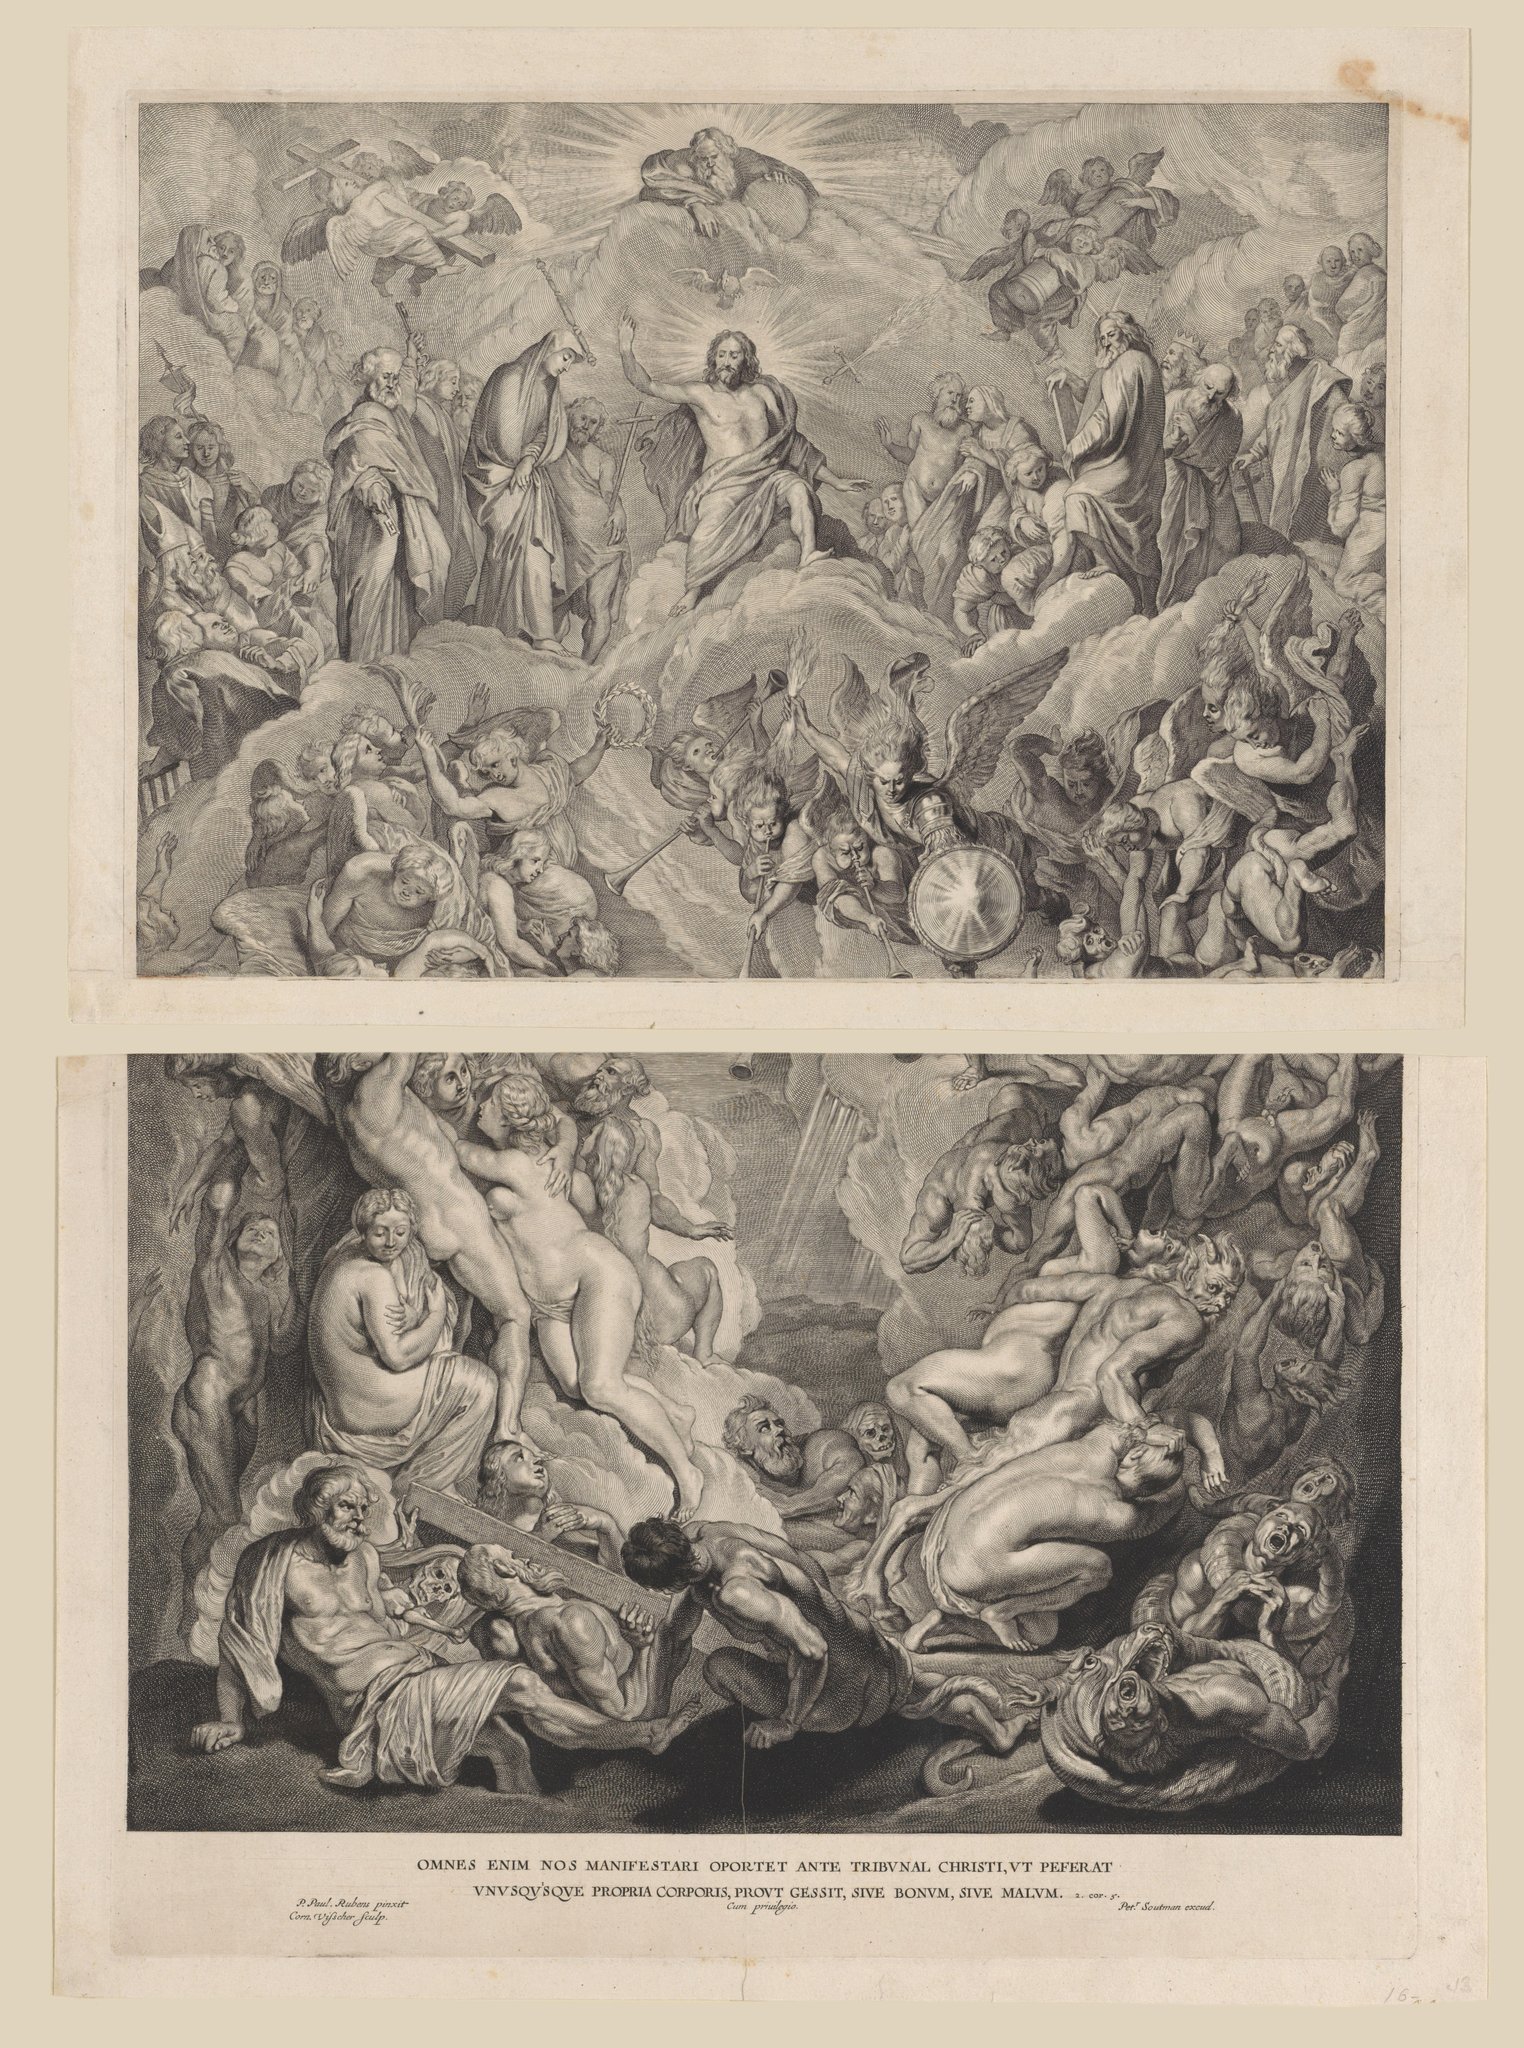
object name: print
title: Laatste Oordeel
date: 1644-1650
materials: paper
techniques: engraving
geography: haarlem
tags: last judgement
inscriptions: collector's mark: Lugt 240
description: Christus zit tronend als rechter op een wolk in de hemel bij het Laatste oordeel. Hij maakt een spreekgebaar en wordt omringd door engelen, koningen, kerkvaders en zijn apostelen. Boven hem vliegt een duif en ligt God met de wereldbol op een wolk. Onder de engelen worden vrouwen en mannen door allerlei duivels en beesten aangevallen en meegevoerd naar de hel.